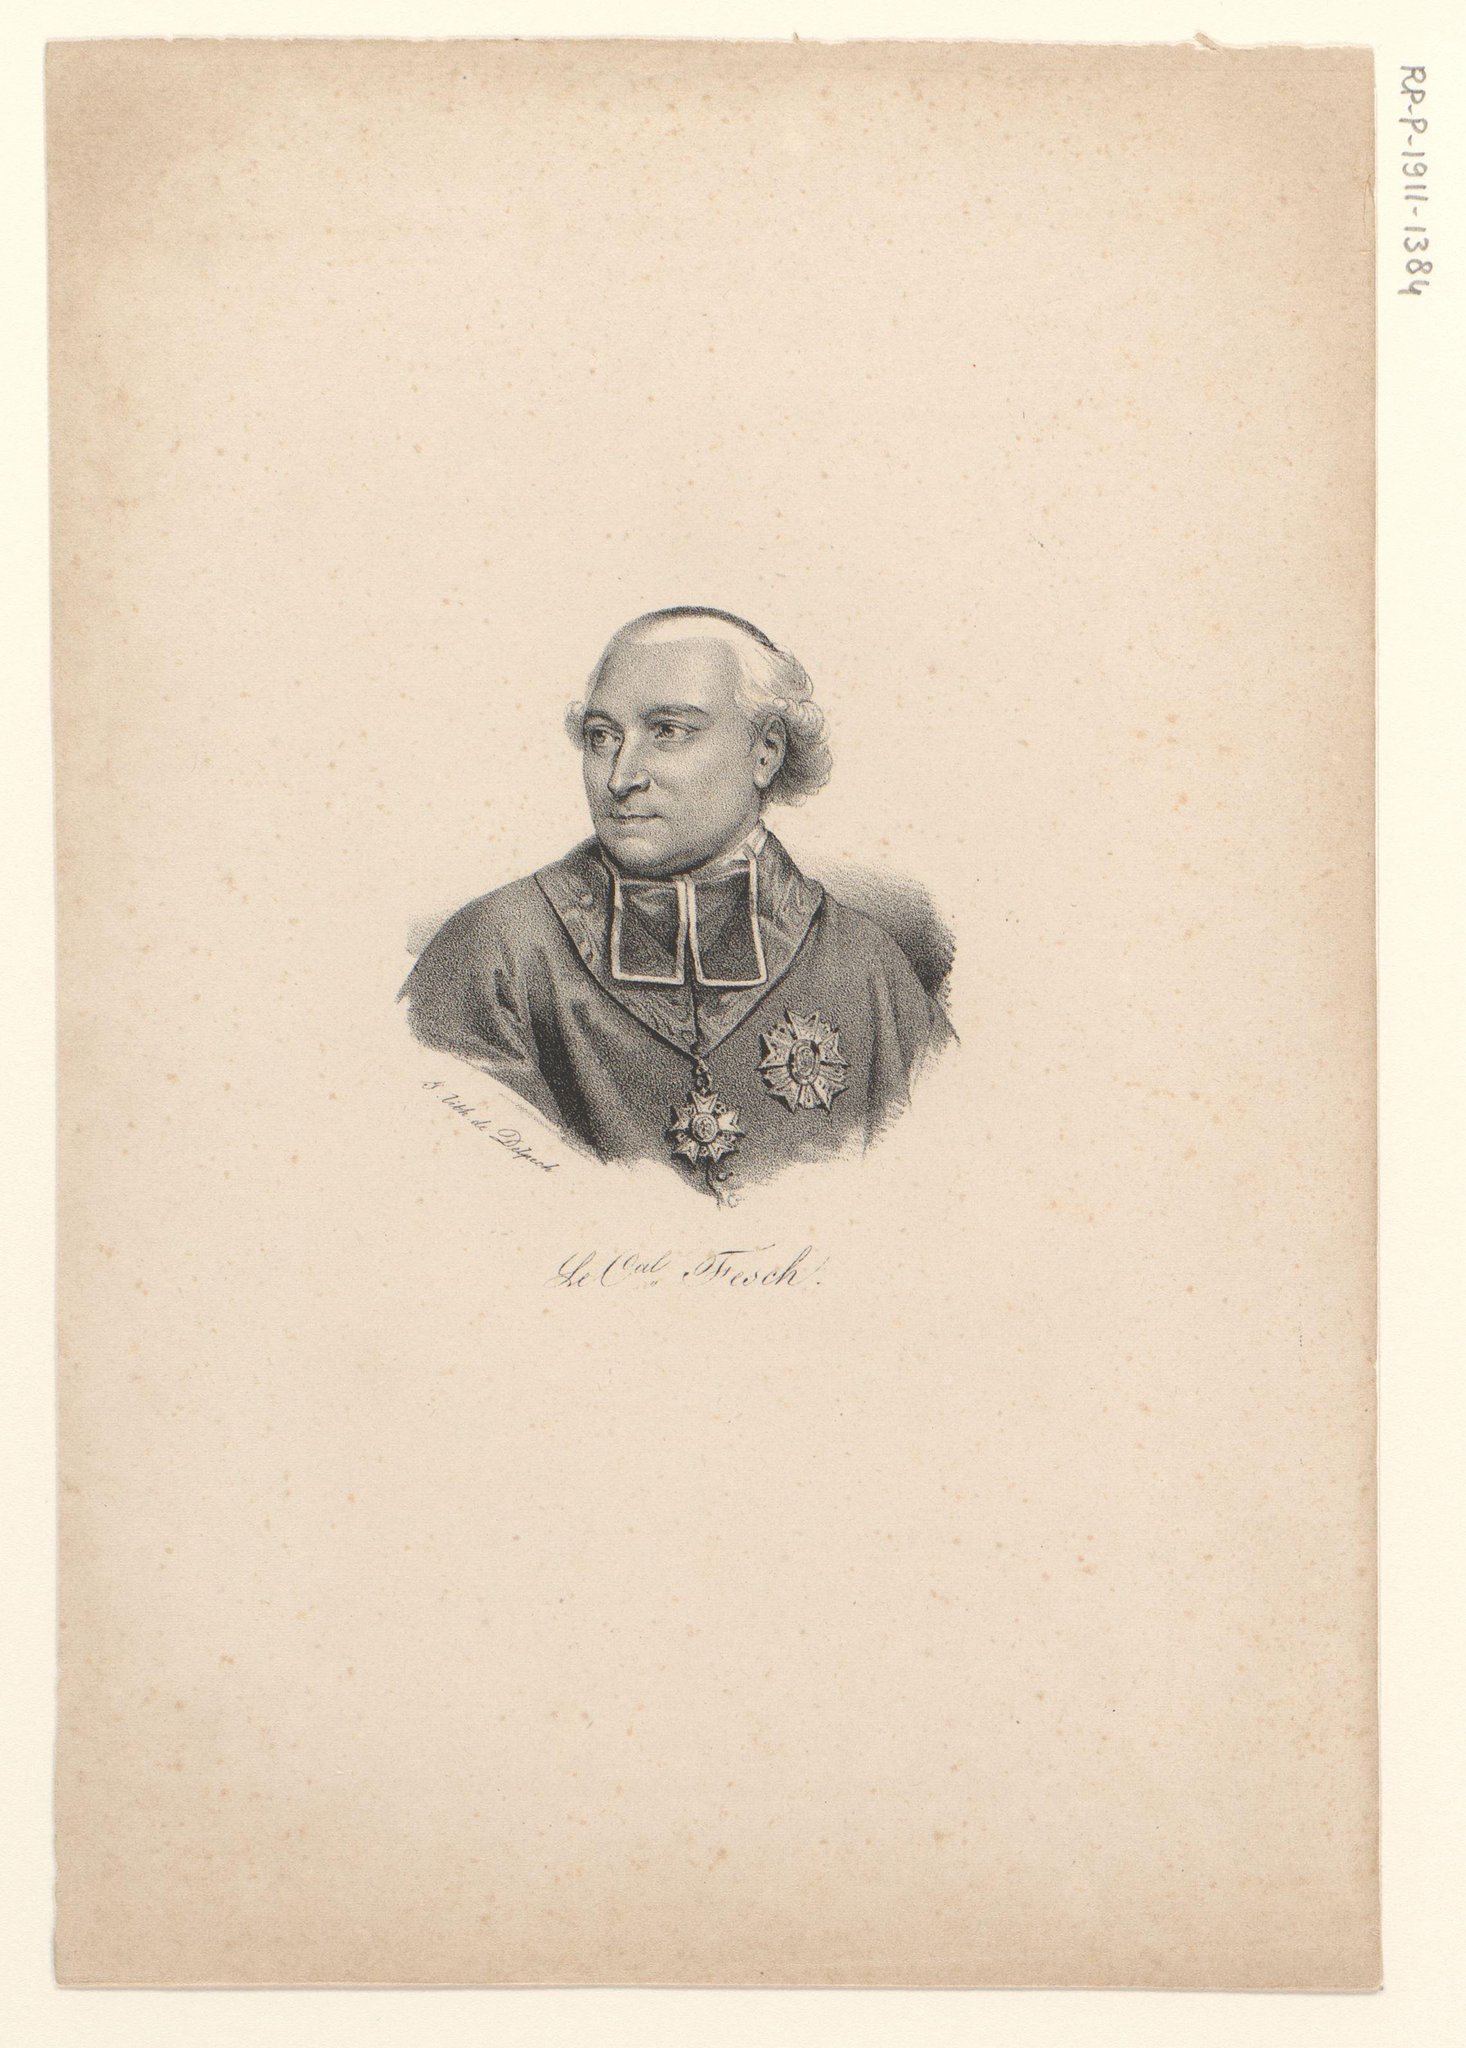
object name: print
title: Le C.al Fesch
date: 1818-1842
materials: paper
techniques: lithograph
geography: paris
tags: rome, historical persons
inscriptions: collector's mark: Lugt 2228a